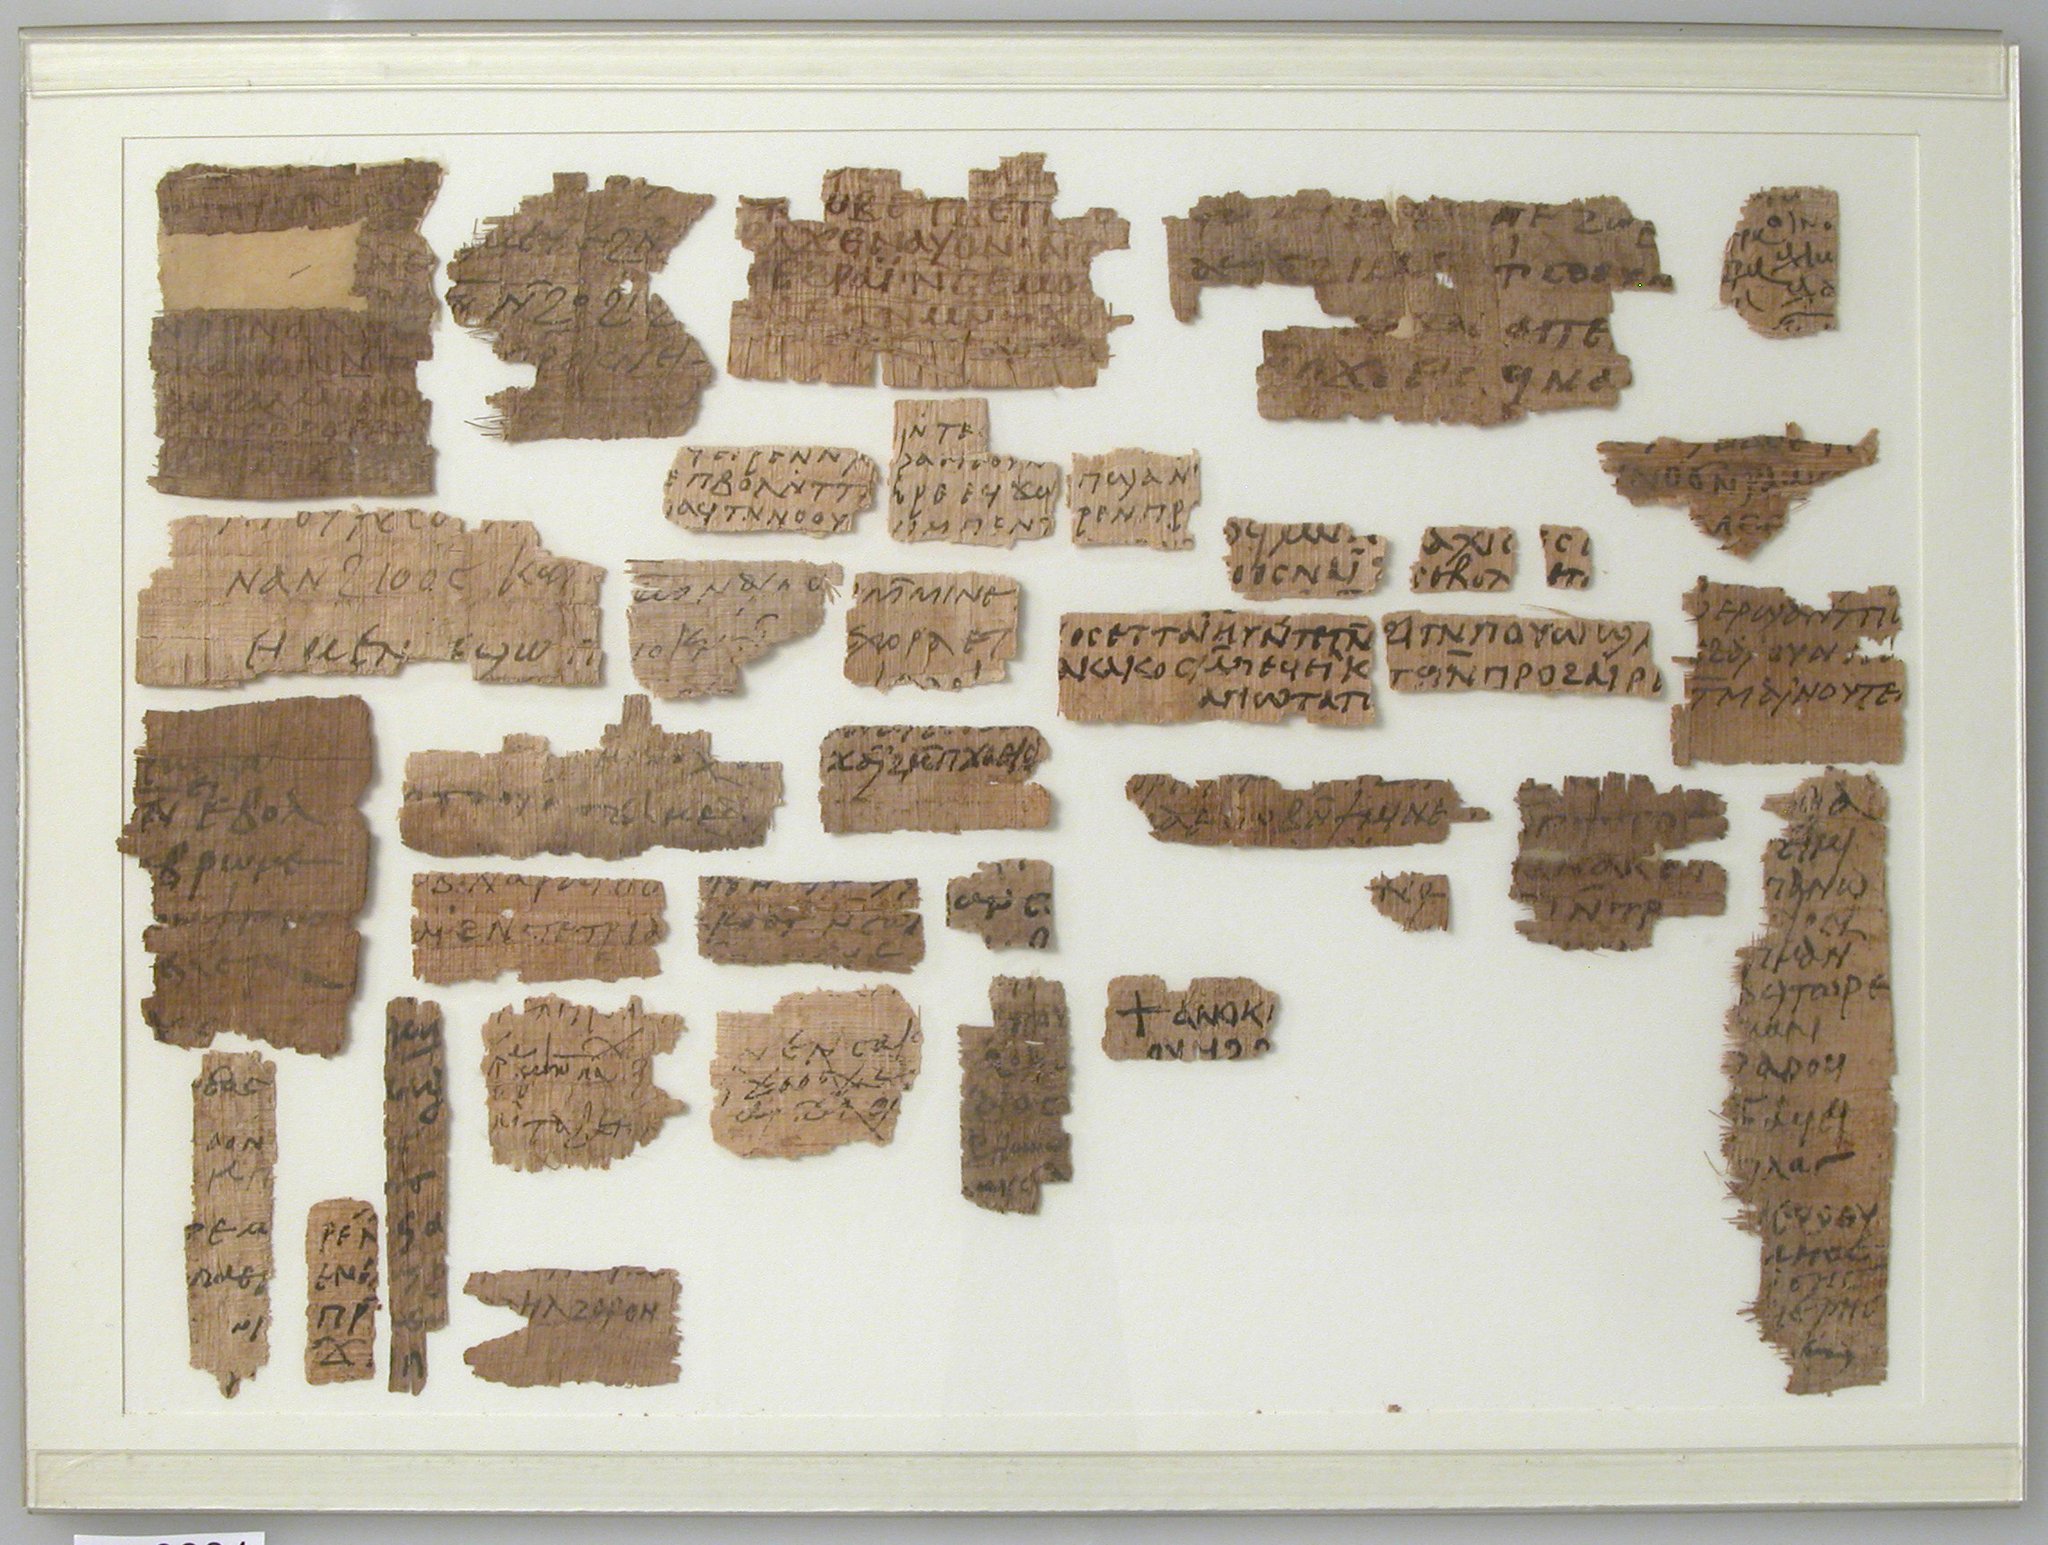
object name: fragment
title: Papyri Fragments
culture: coptic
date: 601-700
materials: ink, papyrus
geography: egypt